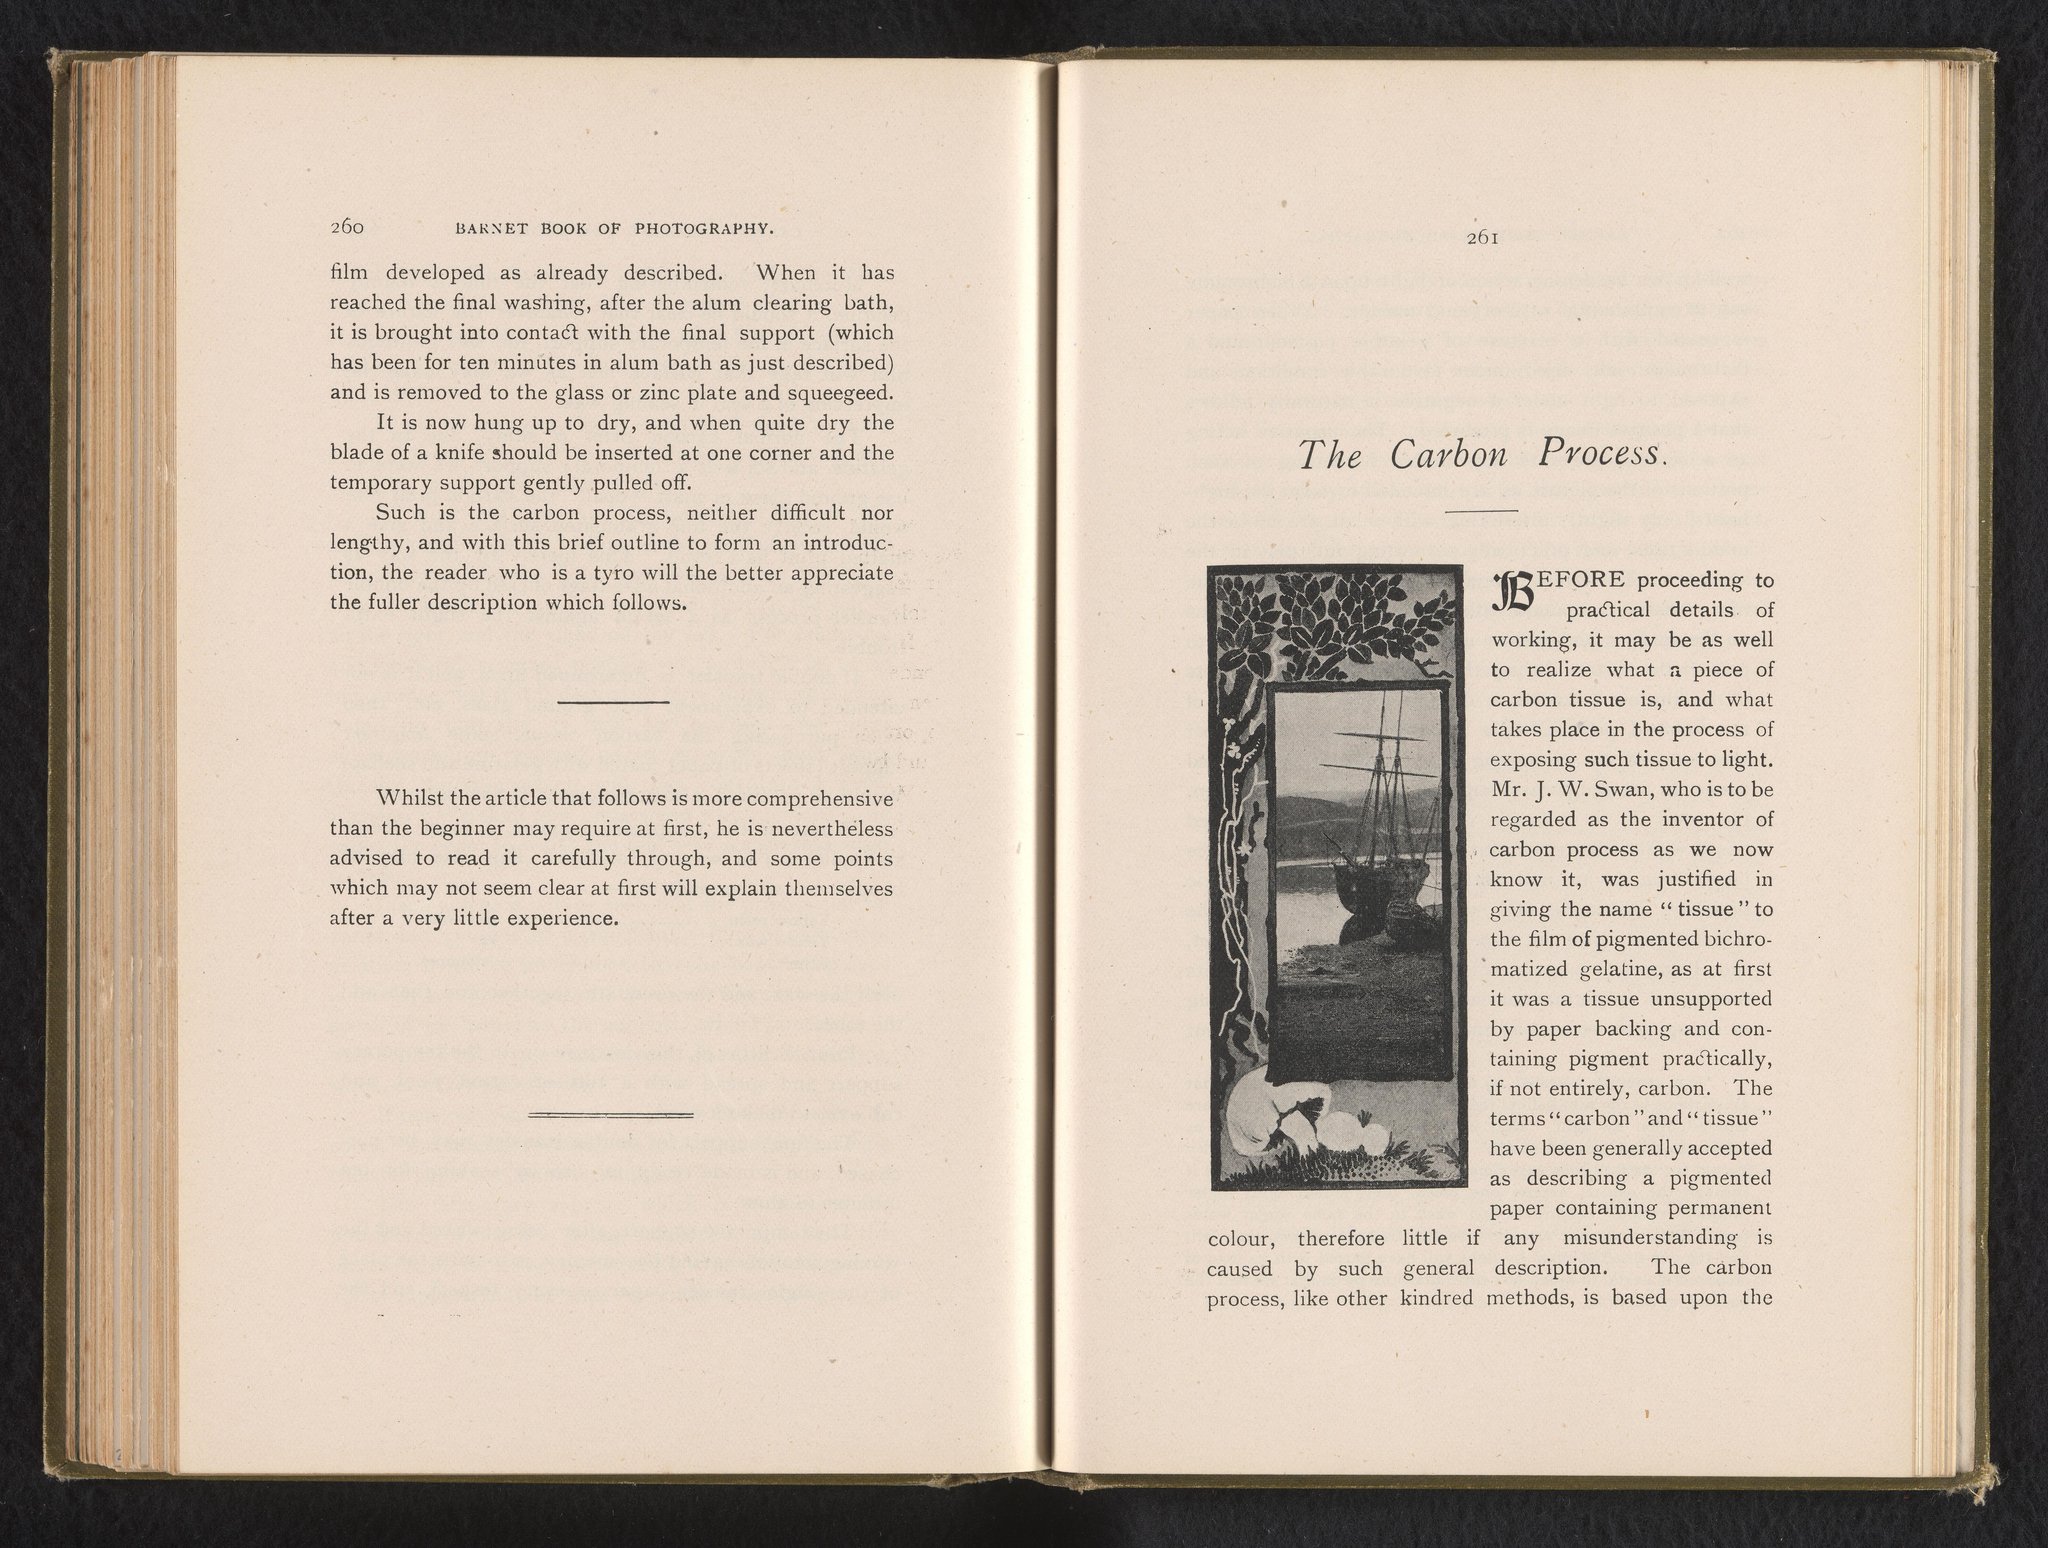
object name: photomechanical print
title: Zeilboot omlijst met graan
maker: Anonymous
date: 1895-1900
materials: paper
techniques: letterpress printing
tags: plants and herbs: wheat, sailing-ship, sailing-boat